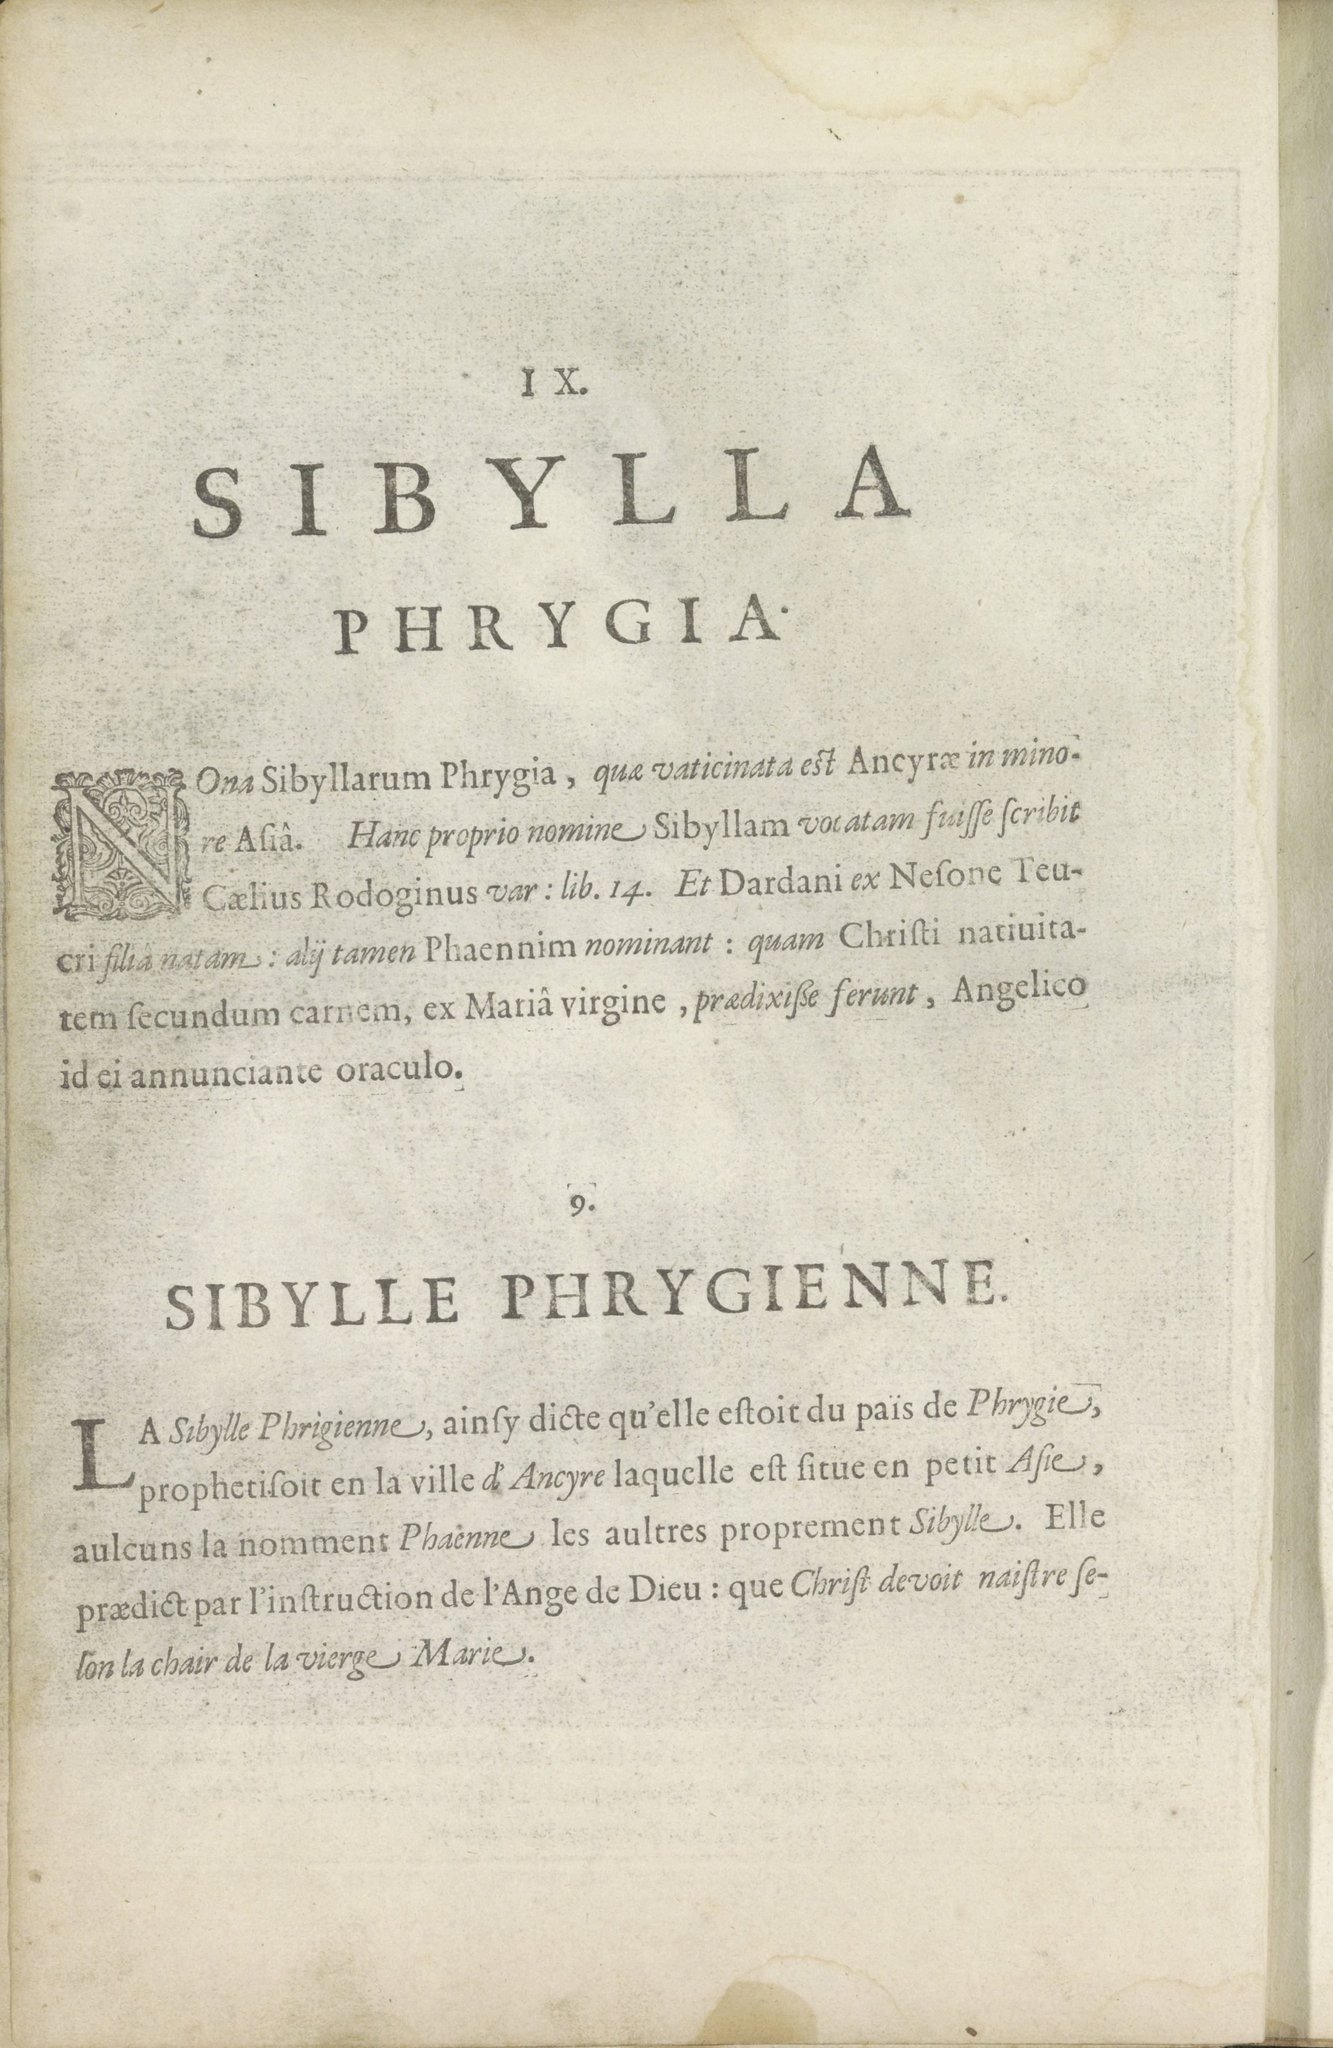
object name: album leaf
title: Sibillen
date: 1615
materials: paper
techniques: letterpress printing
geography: utrecht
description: Een tekst in het Latijn en het Frans over een prent met een voorstelling van de Frygische Sibille. Dit blad maakt deel uit van een album.